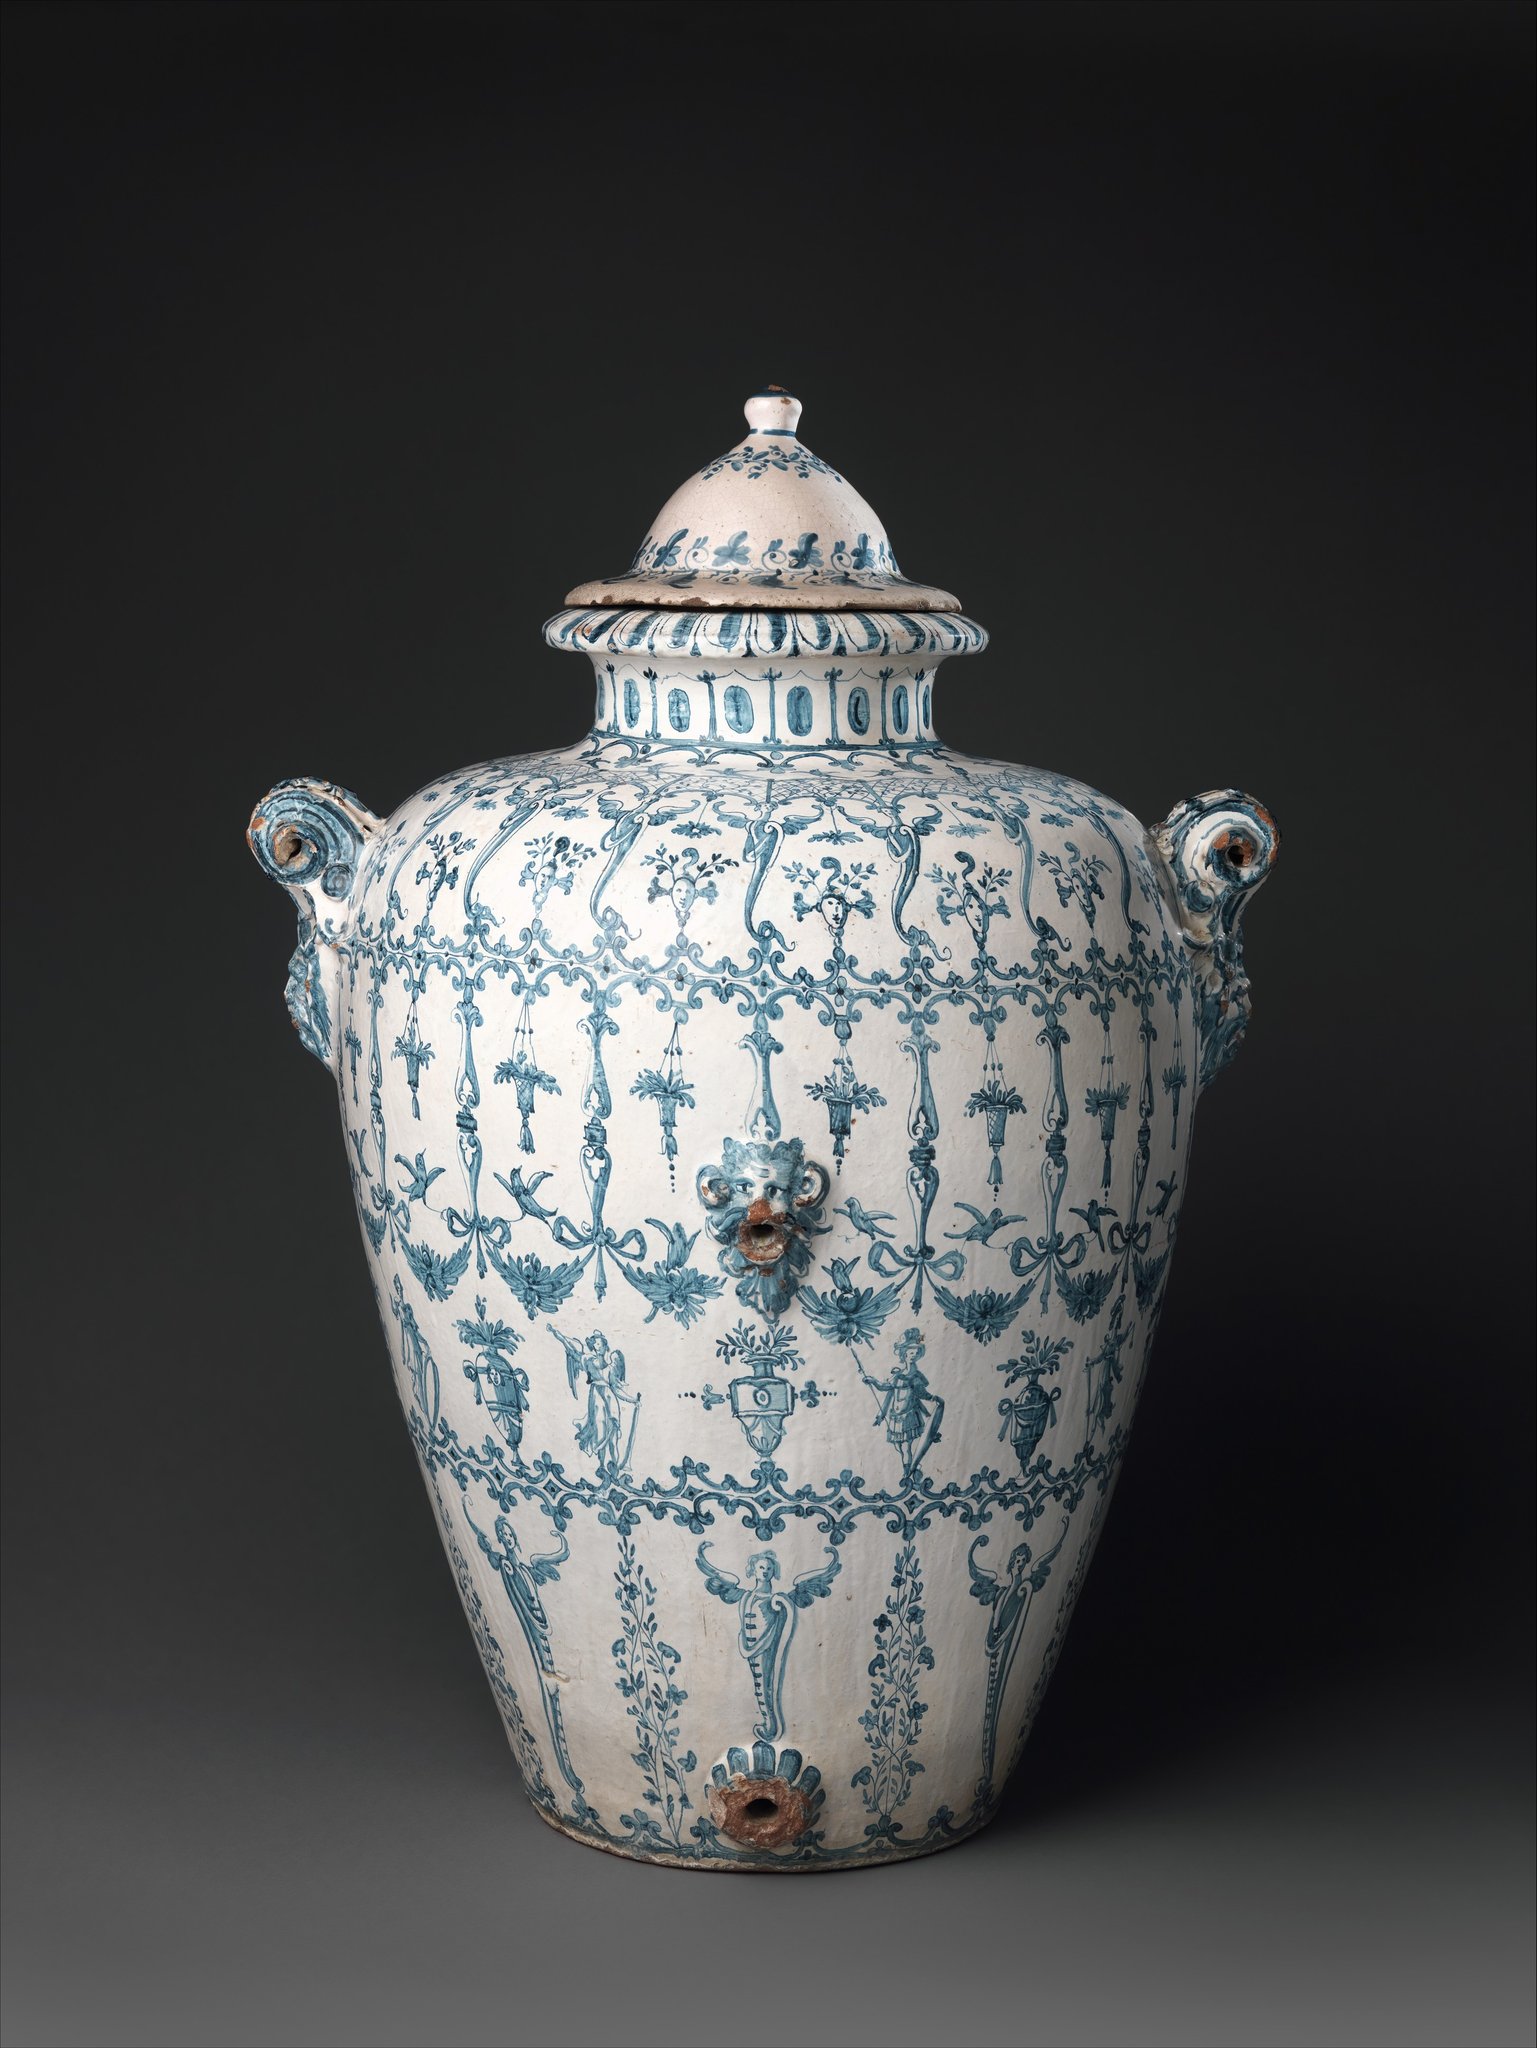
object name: jar, wine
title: Wine jar (Orcio da vino)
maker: workshop of the marmi family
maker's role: maker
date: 1597-1620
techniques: maiolica, glazing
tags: birds,satyrs